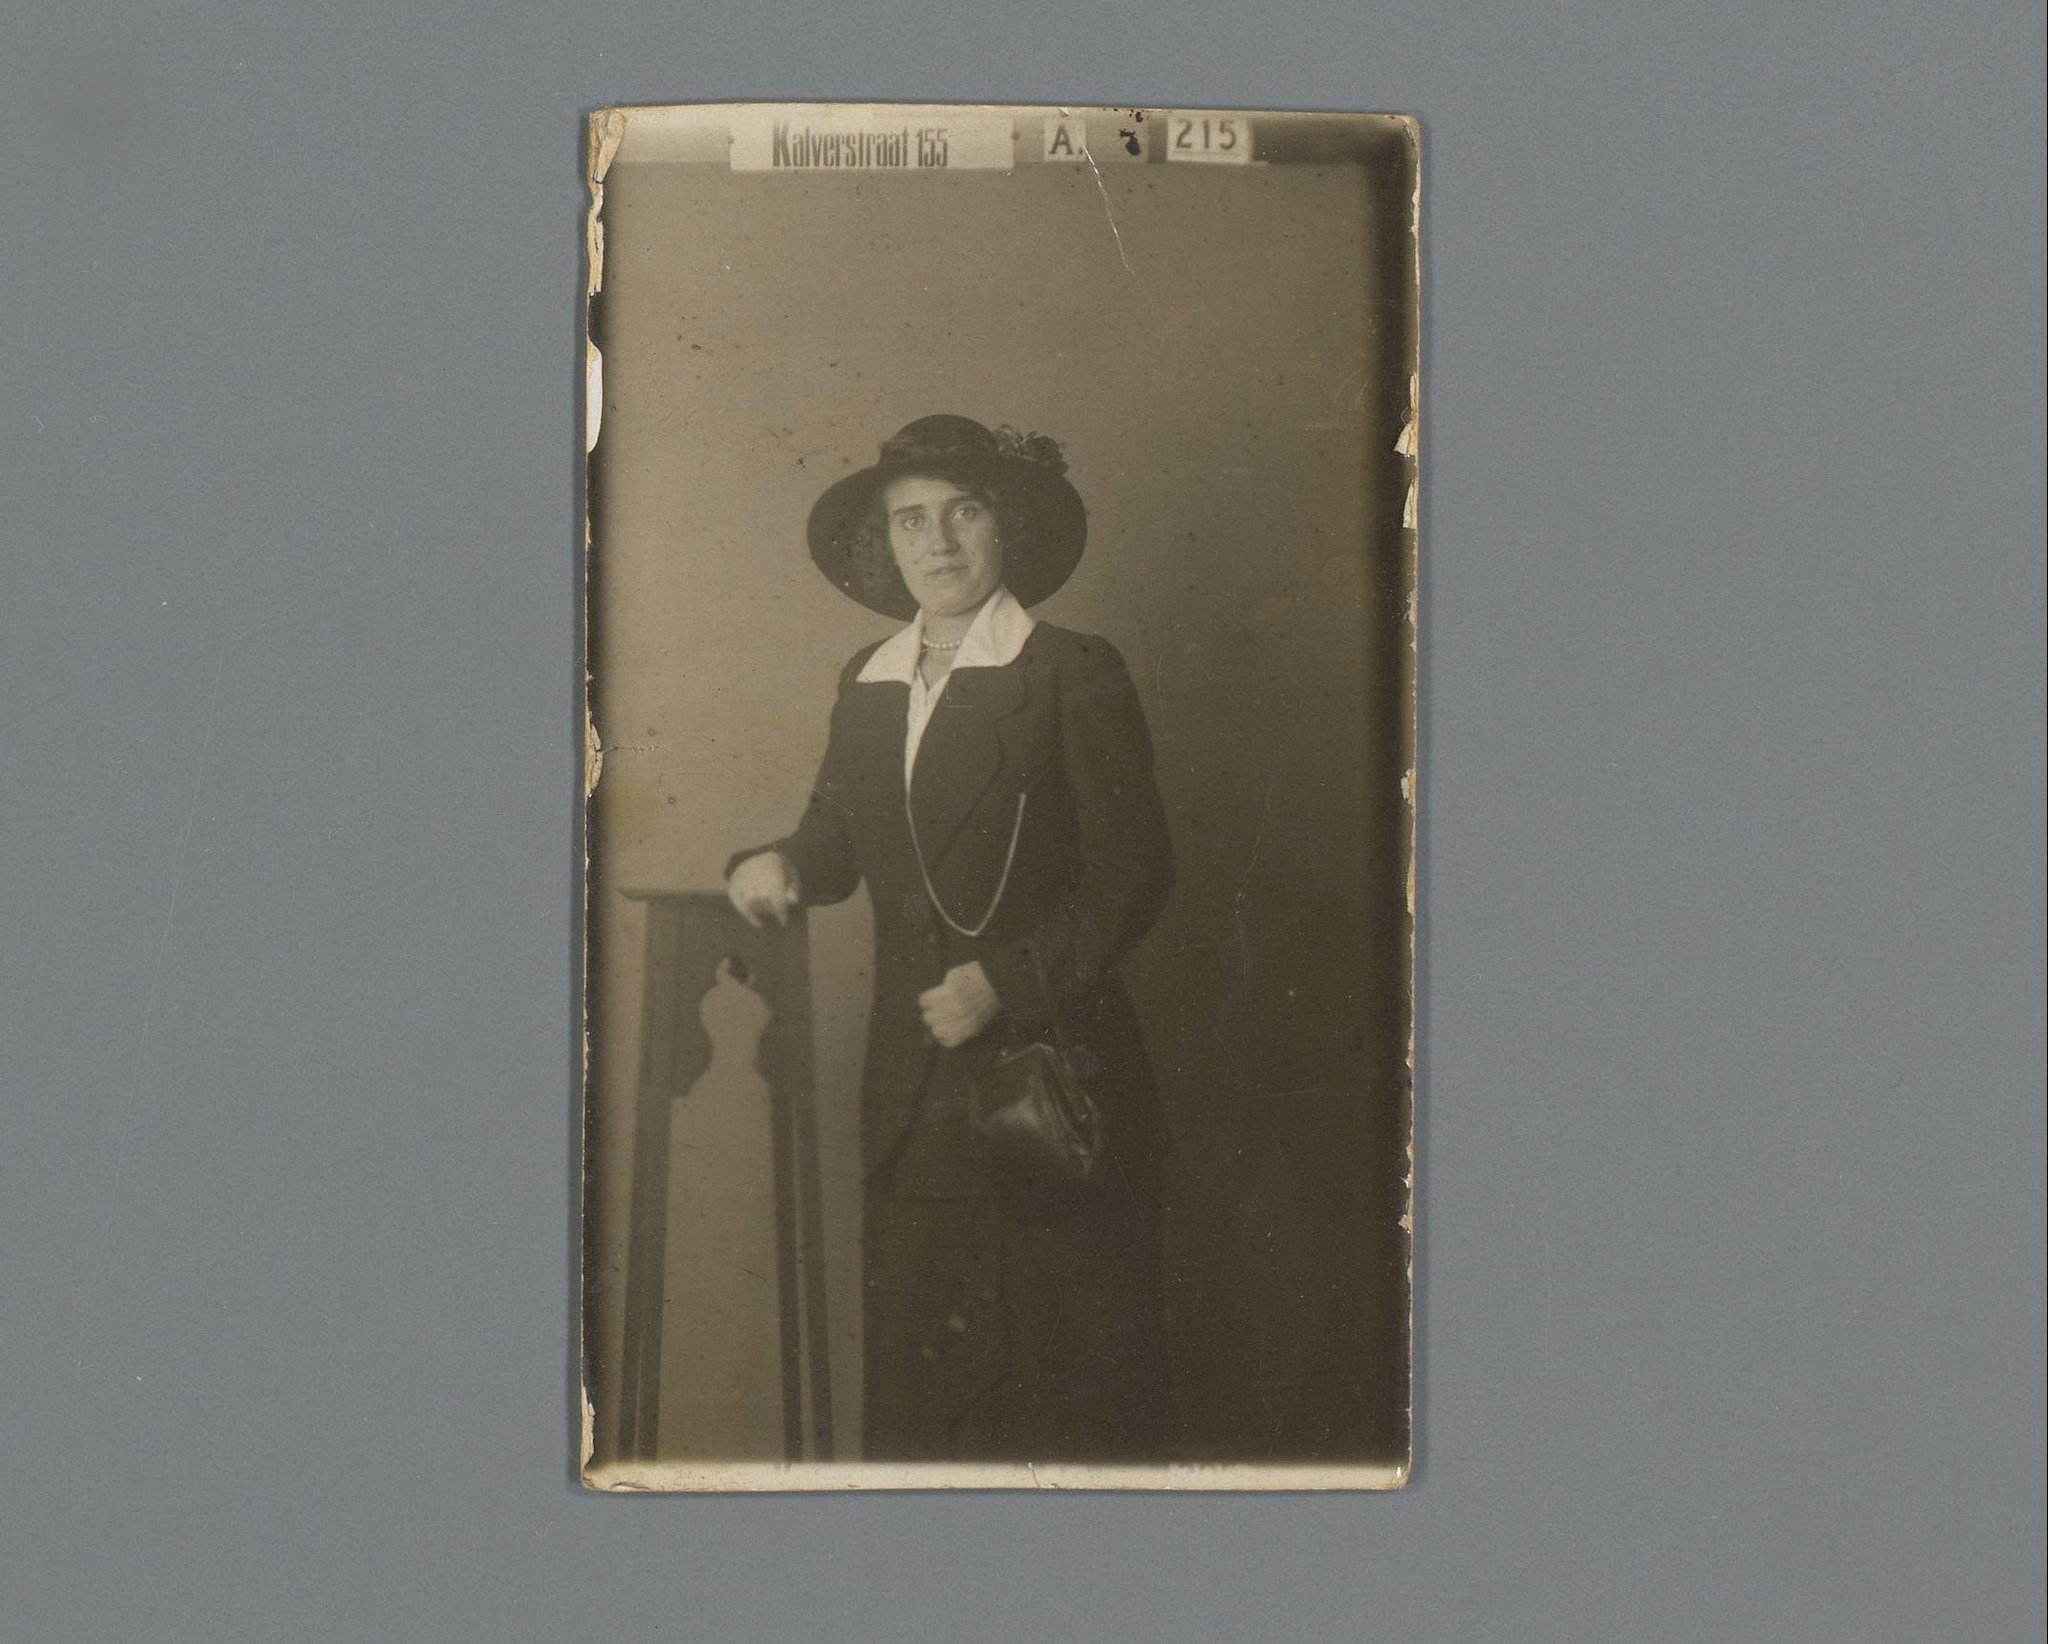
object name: snapshot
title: Portret van een onbekende vrouw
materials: paper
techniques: gelatin silver print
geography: amsterdam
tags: adult woman, anonymous historical person portrayed, amsterdam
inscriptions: address: ‘Kalverstraat 155’